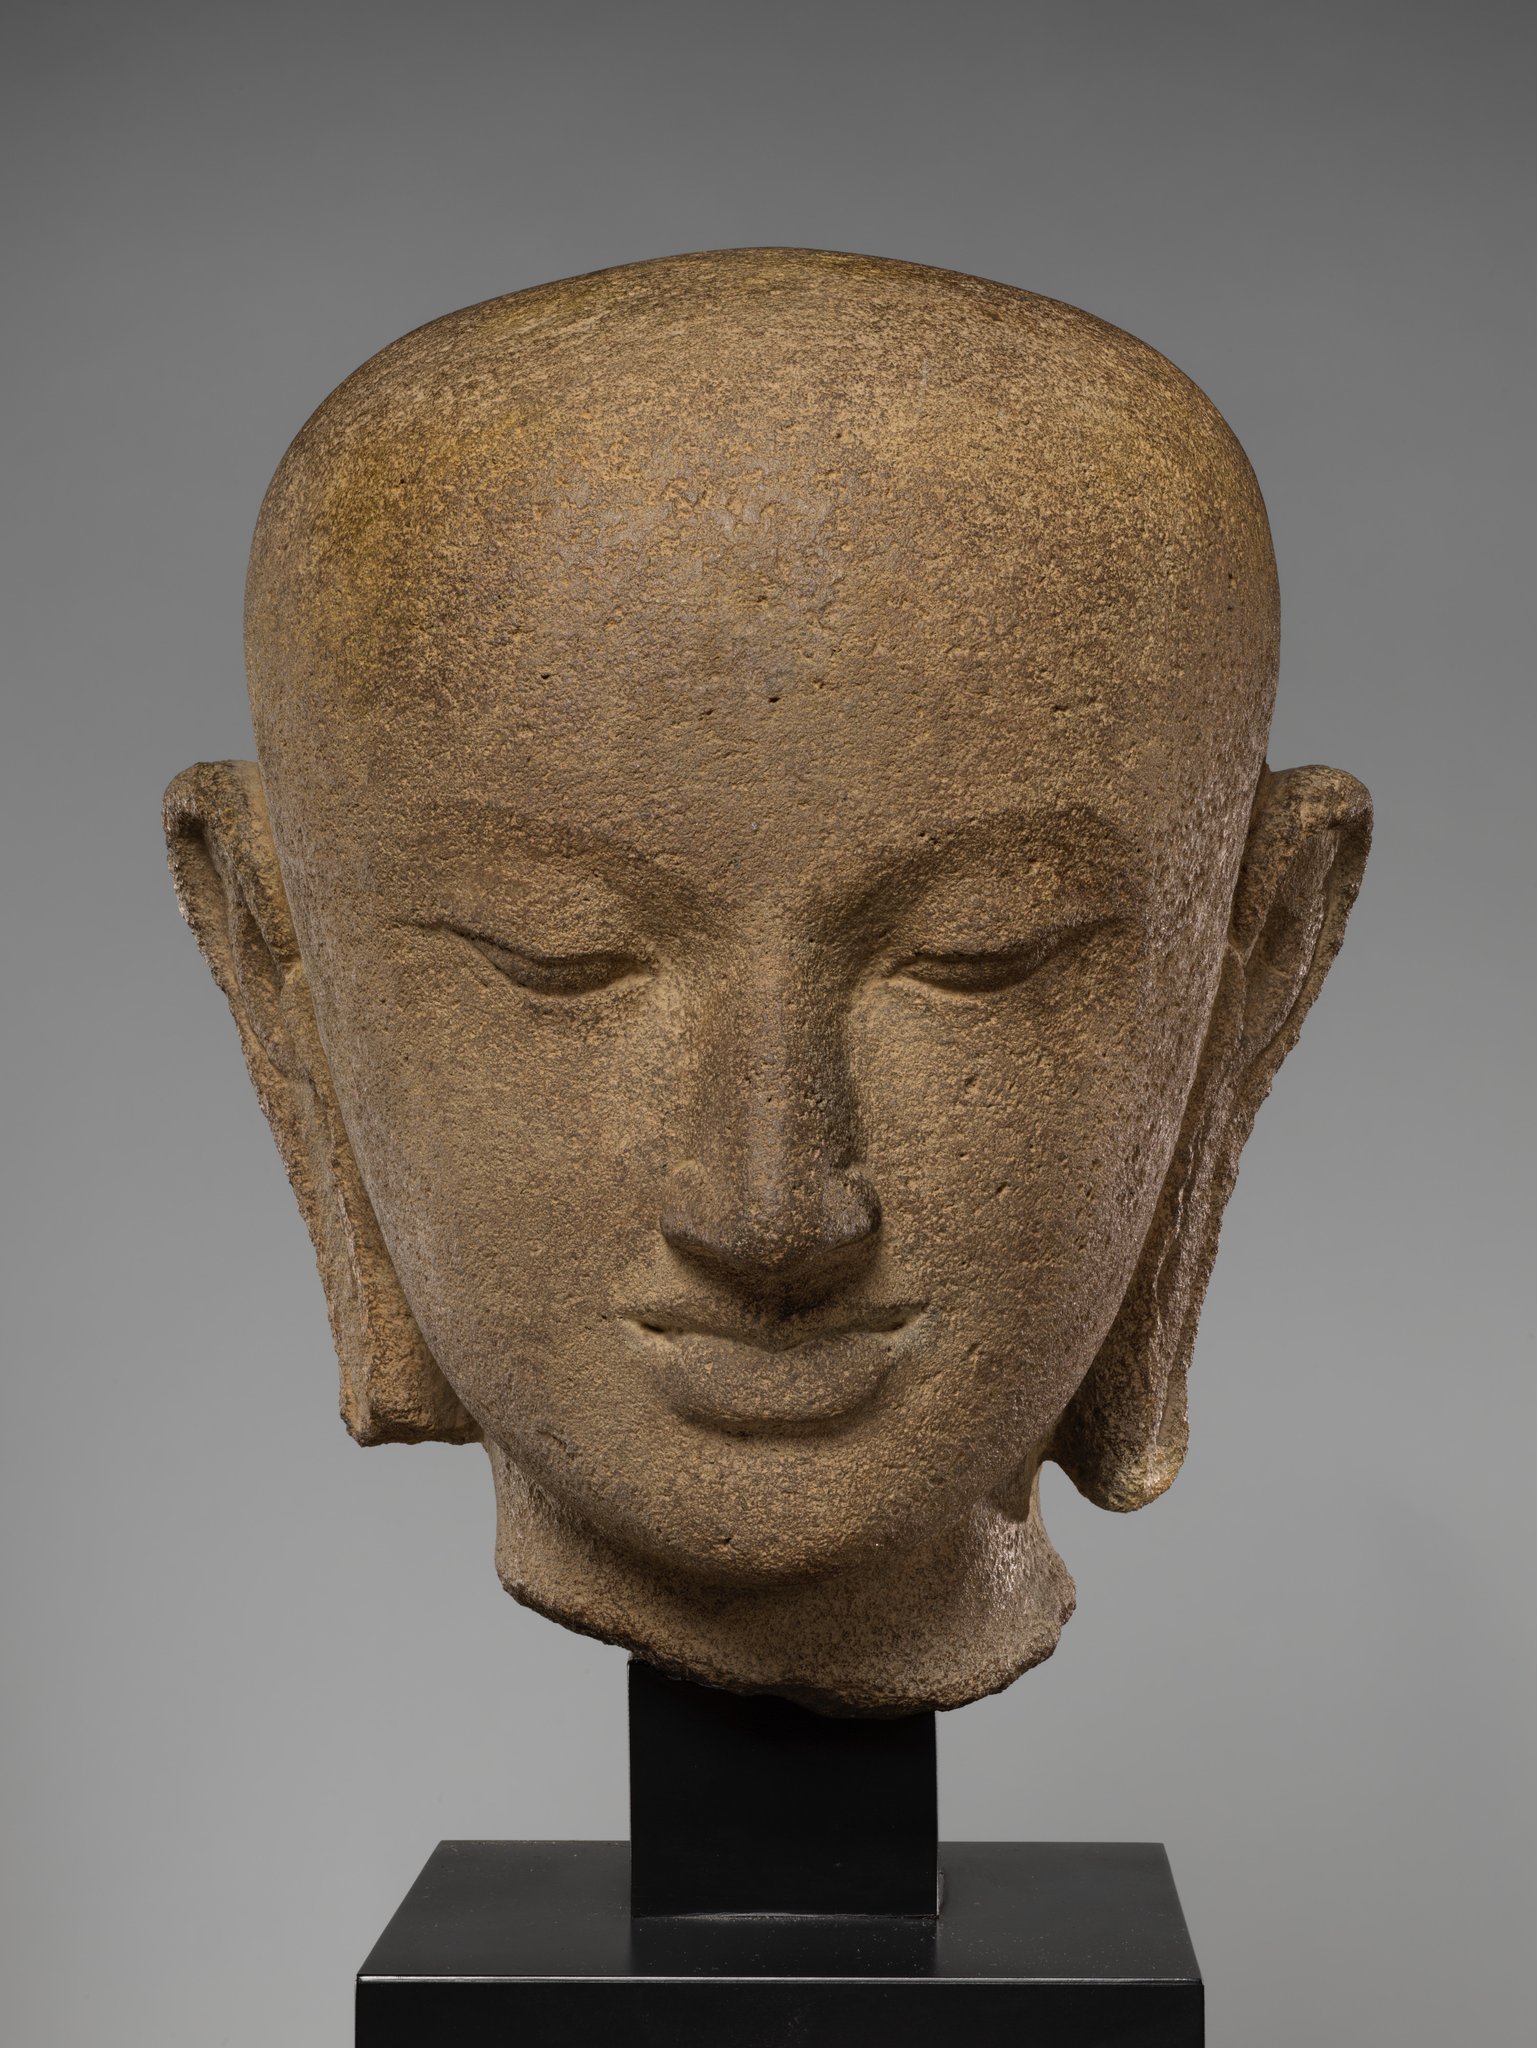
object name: head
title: Head of a Monk (Study Collection)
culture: indonesian, javanese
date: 1901-2000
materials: stone